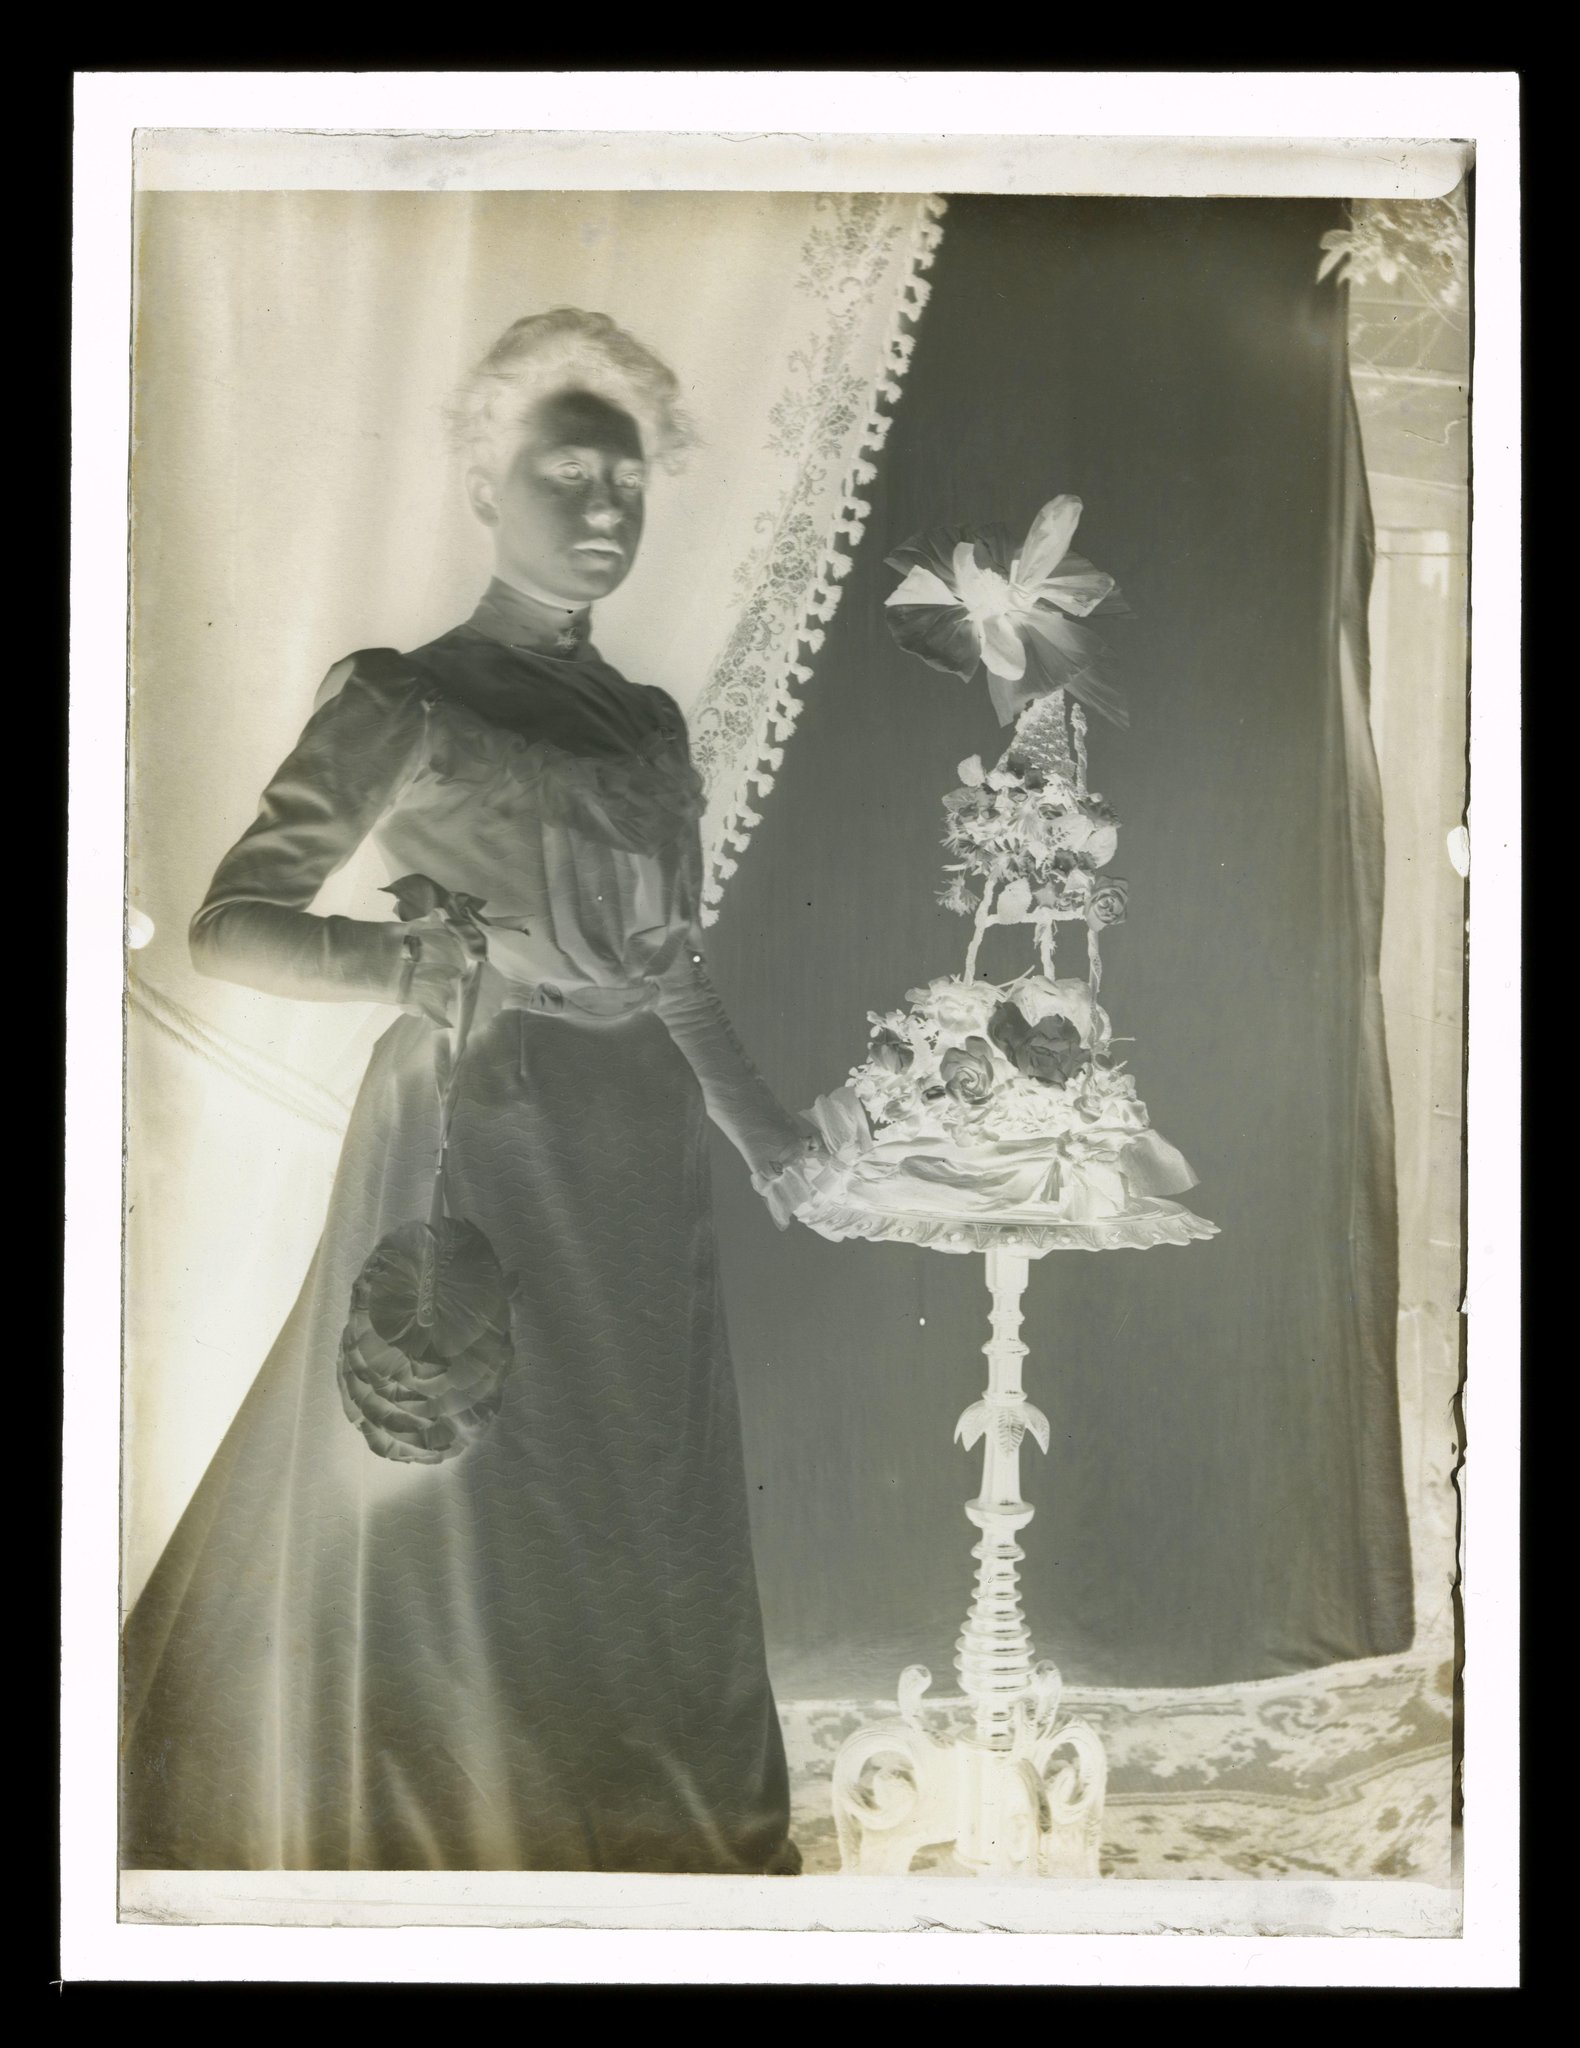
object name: photograph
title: Portret van een onbekende vrouw naast een bijzettafel met bloemstuk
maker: Anonymous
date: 1907-1935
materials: glass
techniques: gelatin glass negative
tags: cut flowers; nosegay, bunch of flowers, historical persons not known by name - bb - woman